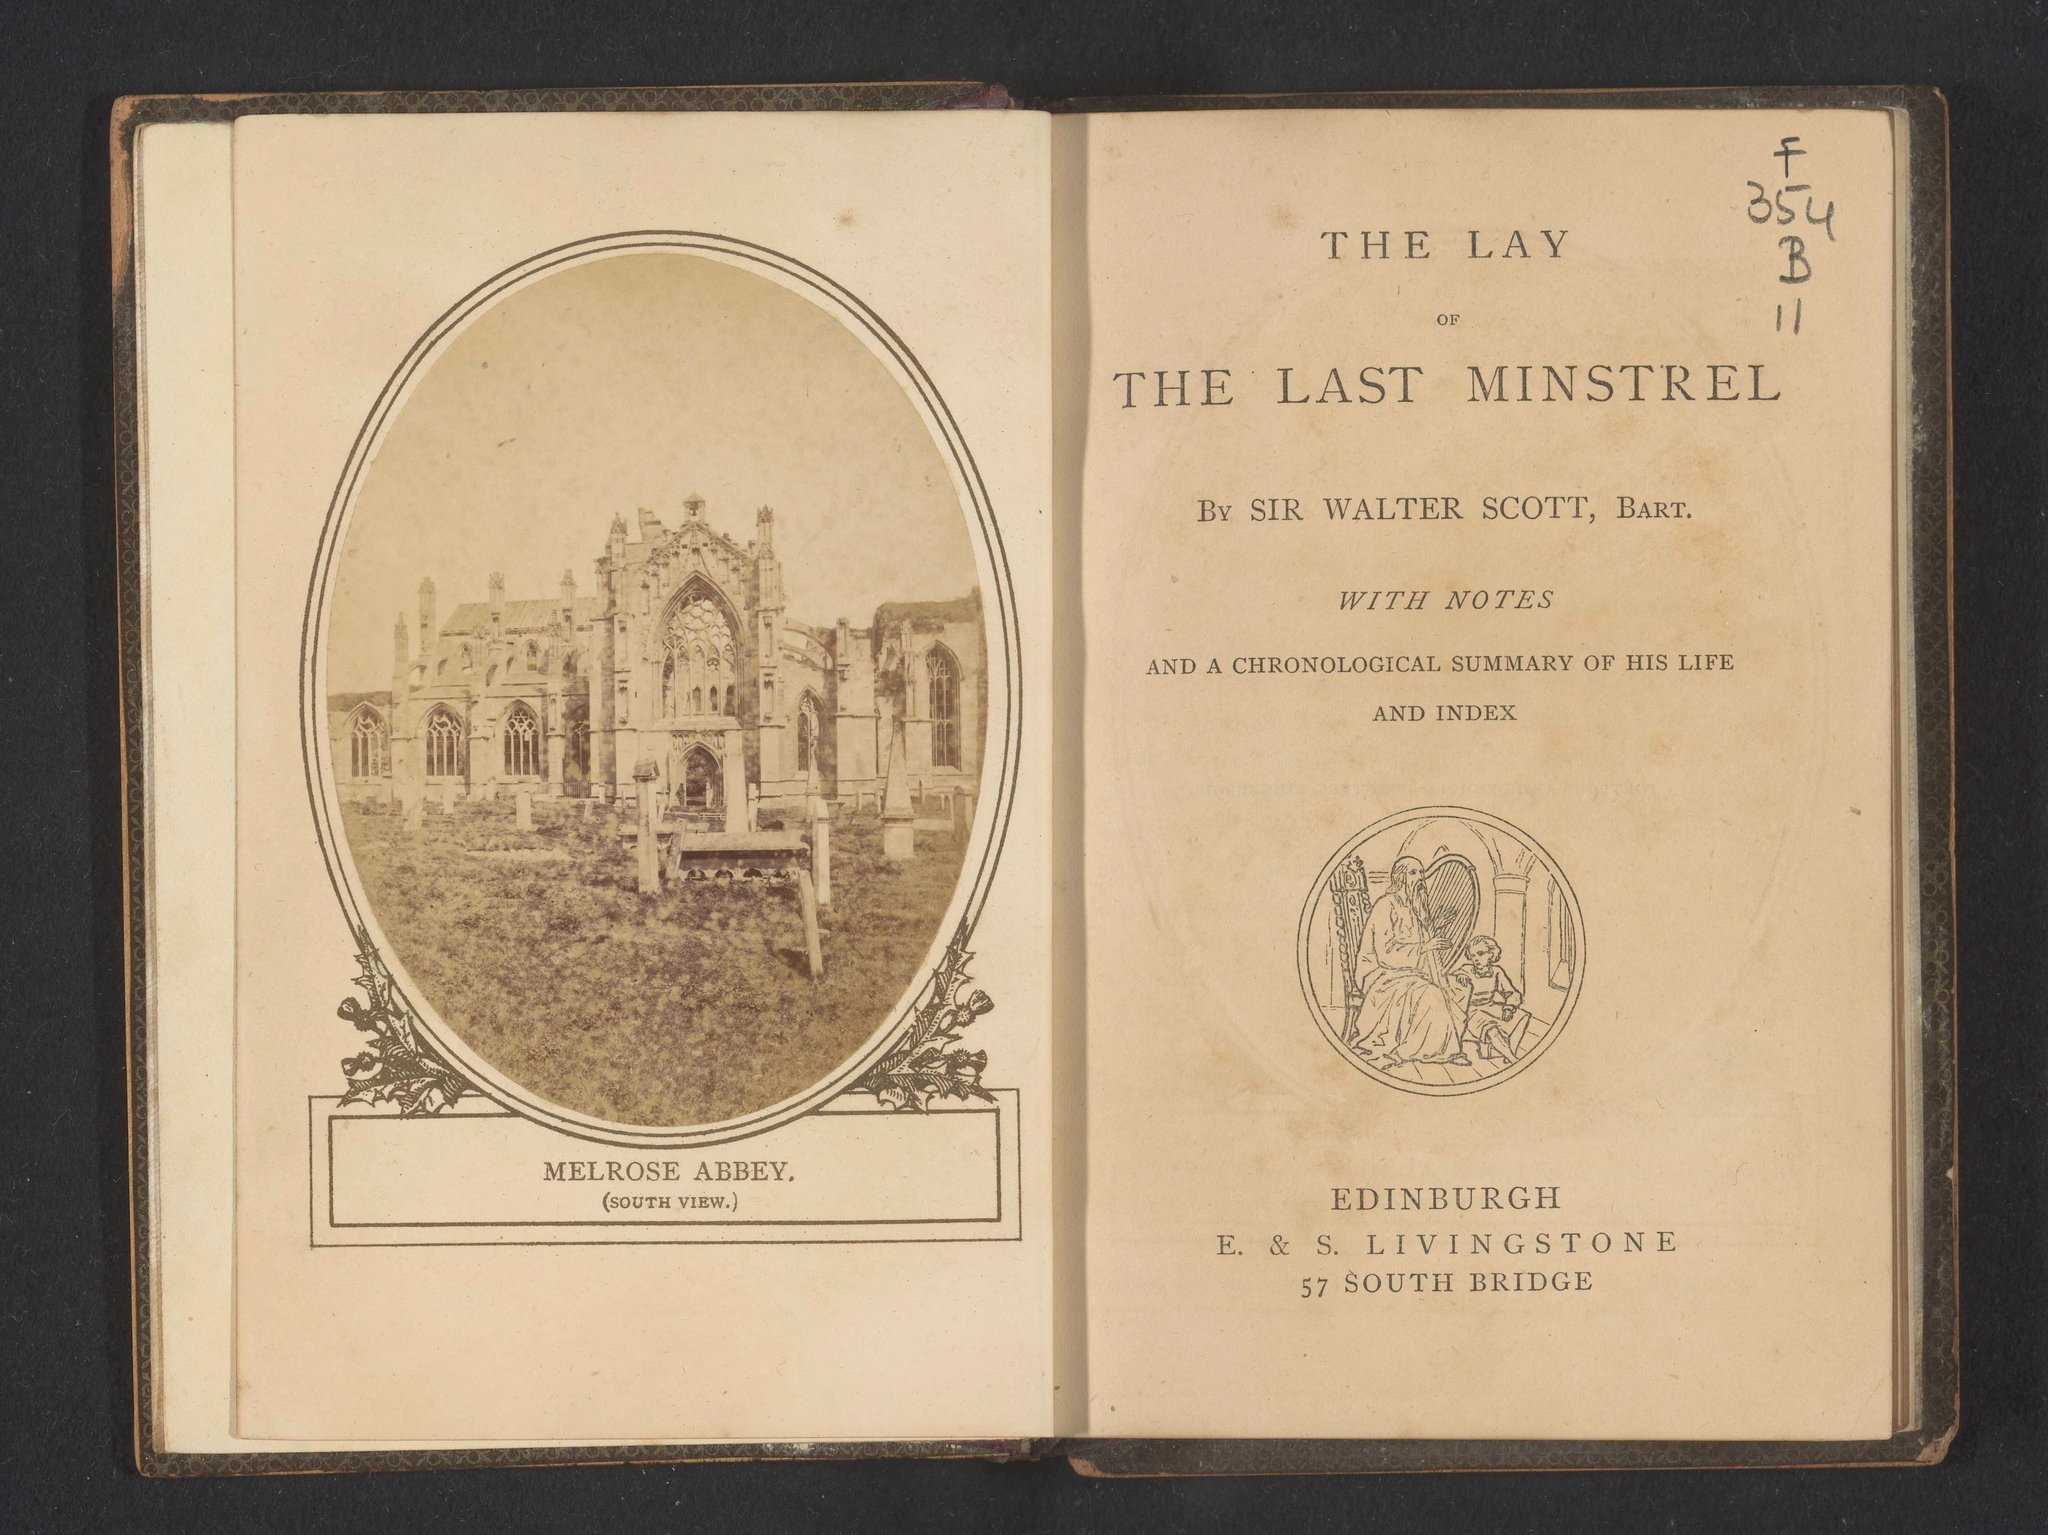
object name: book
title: The lay of the last minstrel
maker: walter scott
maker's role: dichter, schrijver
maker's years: 1771-1832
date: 1871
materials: paper, photographic support, wood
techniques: albumen print, printing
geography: edinburgh